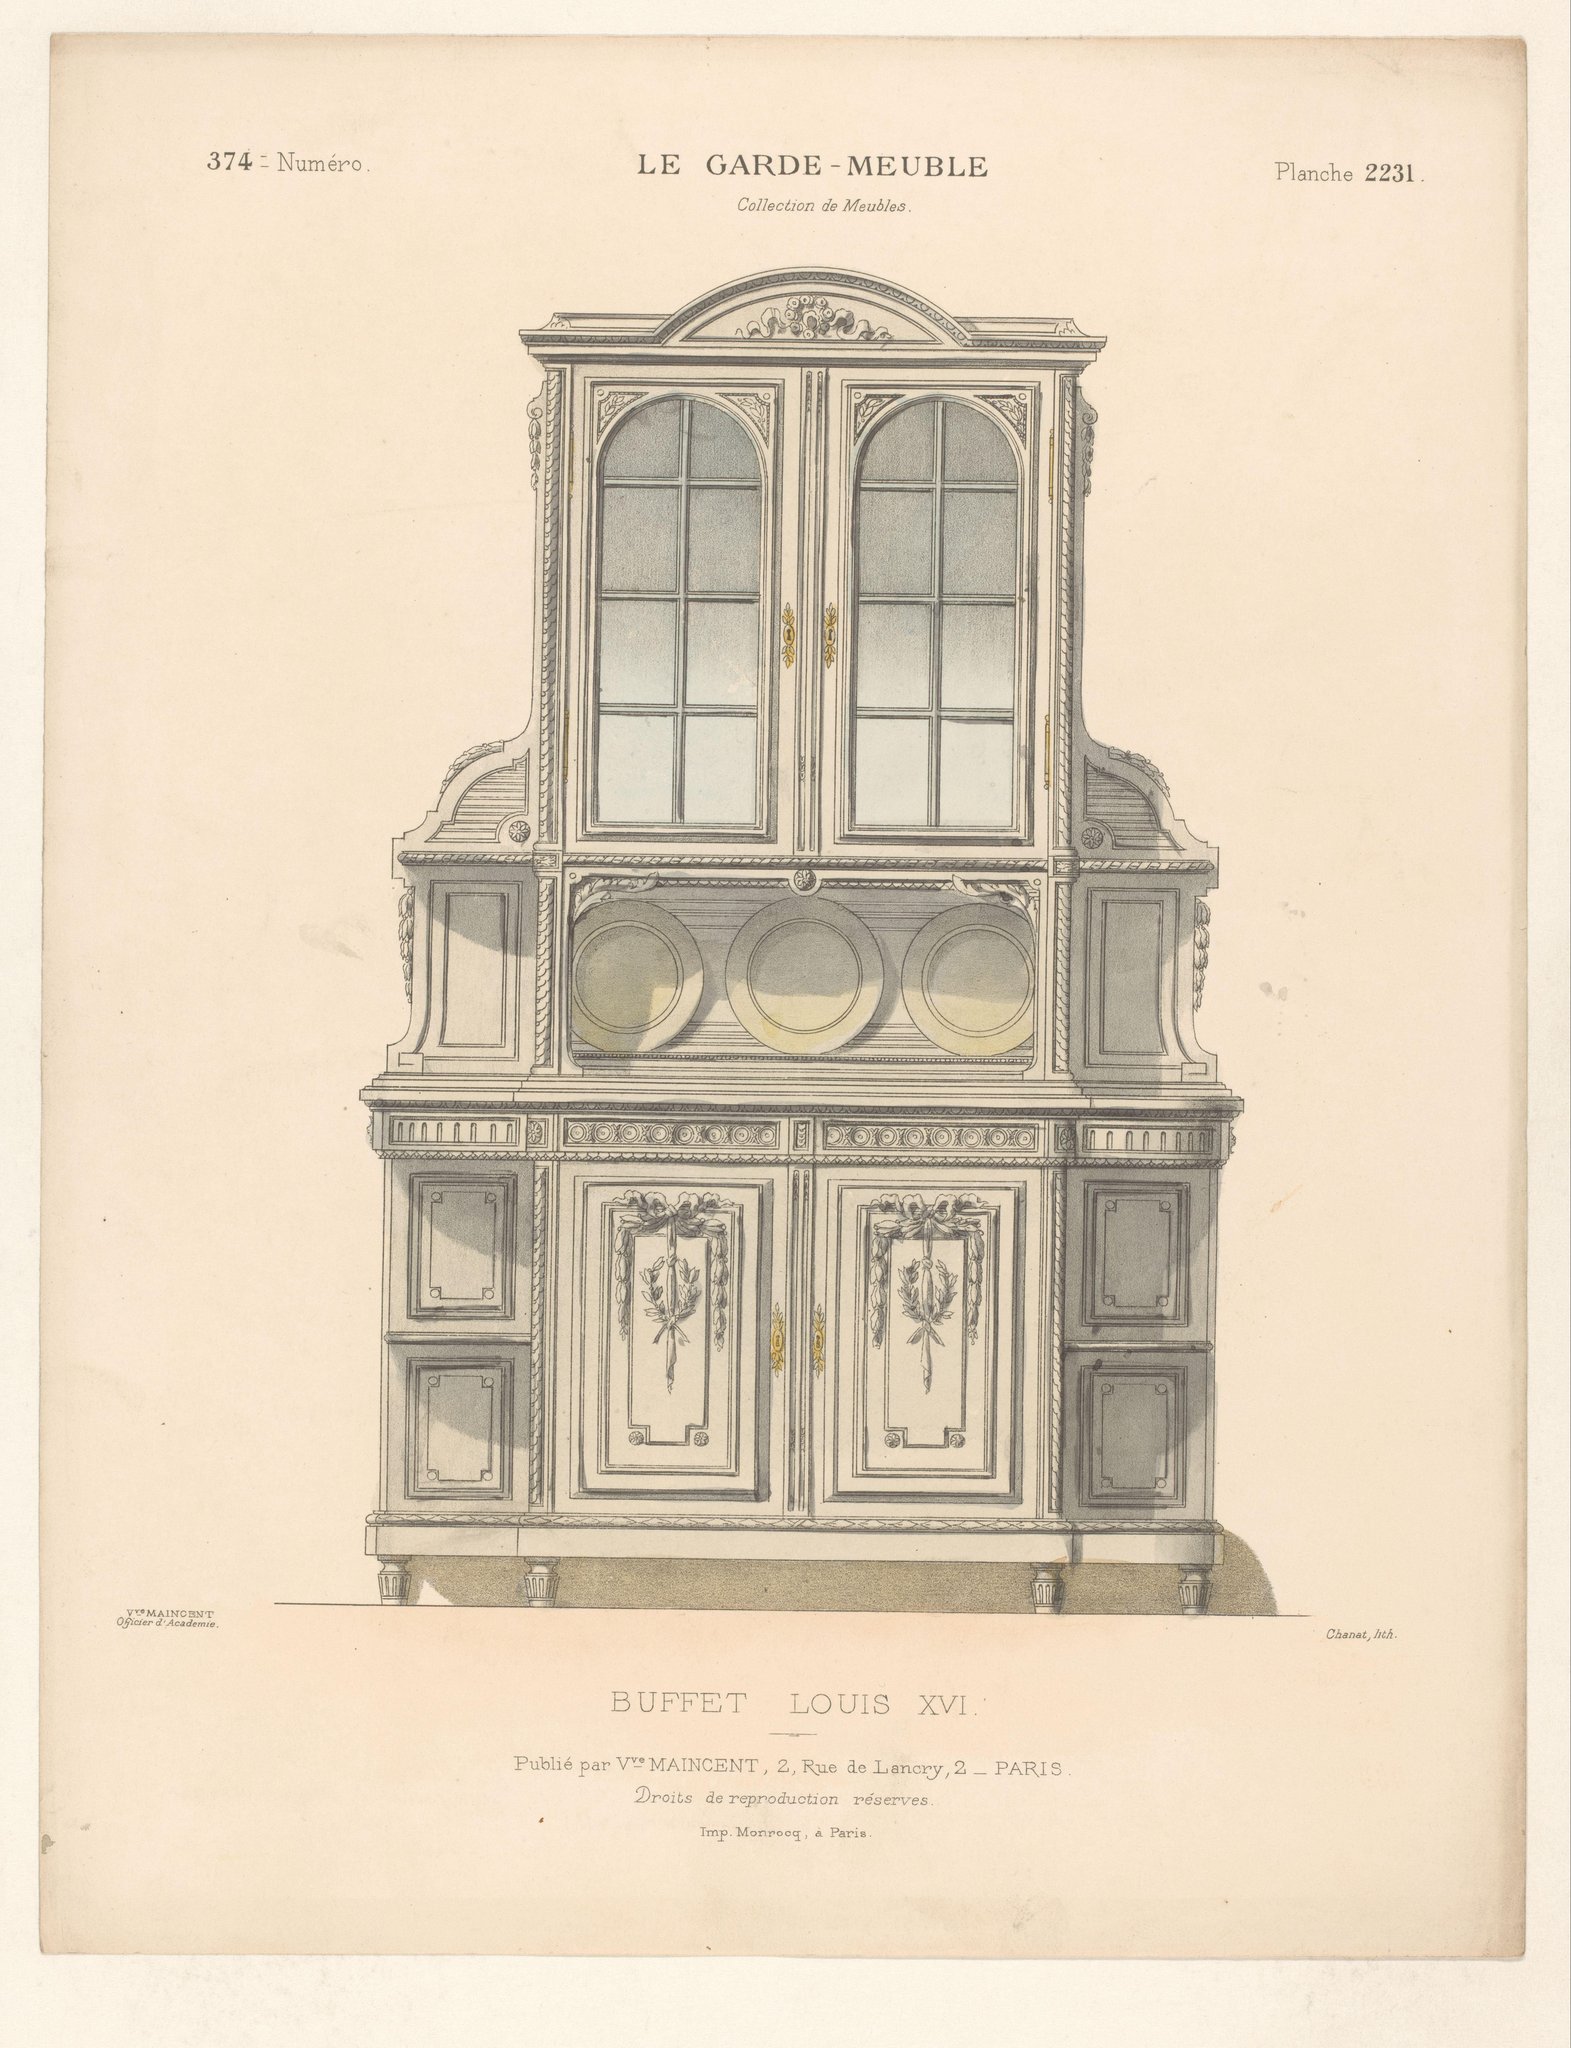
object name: print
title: Buffetkast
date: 1895-1935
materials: paper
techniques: hand coloring, lithograph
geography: paris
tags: furniture for storage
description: Ieder Livraison in de serie Le Garde-Meuble bevat negen platen: drie 'sièges' (zitmeubels), drie 'meubles' (diverse meubels zoals tafels en kasten) en drie 'tentures' (gordijnen en draperieën).